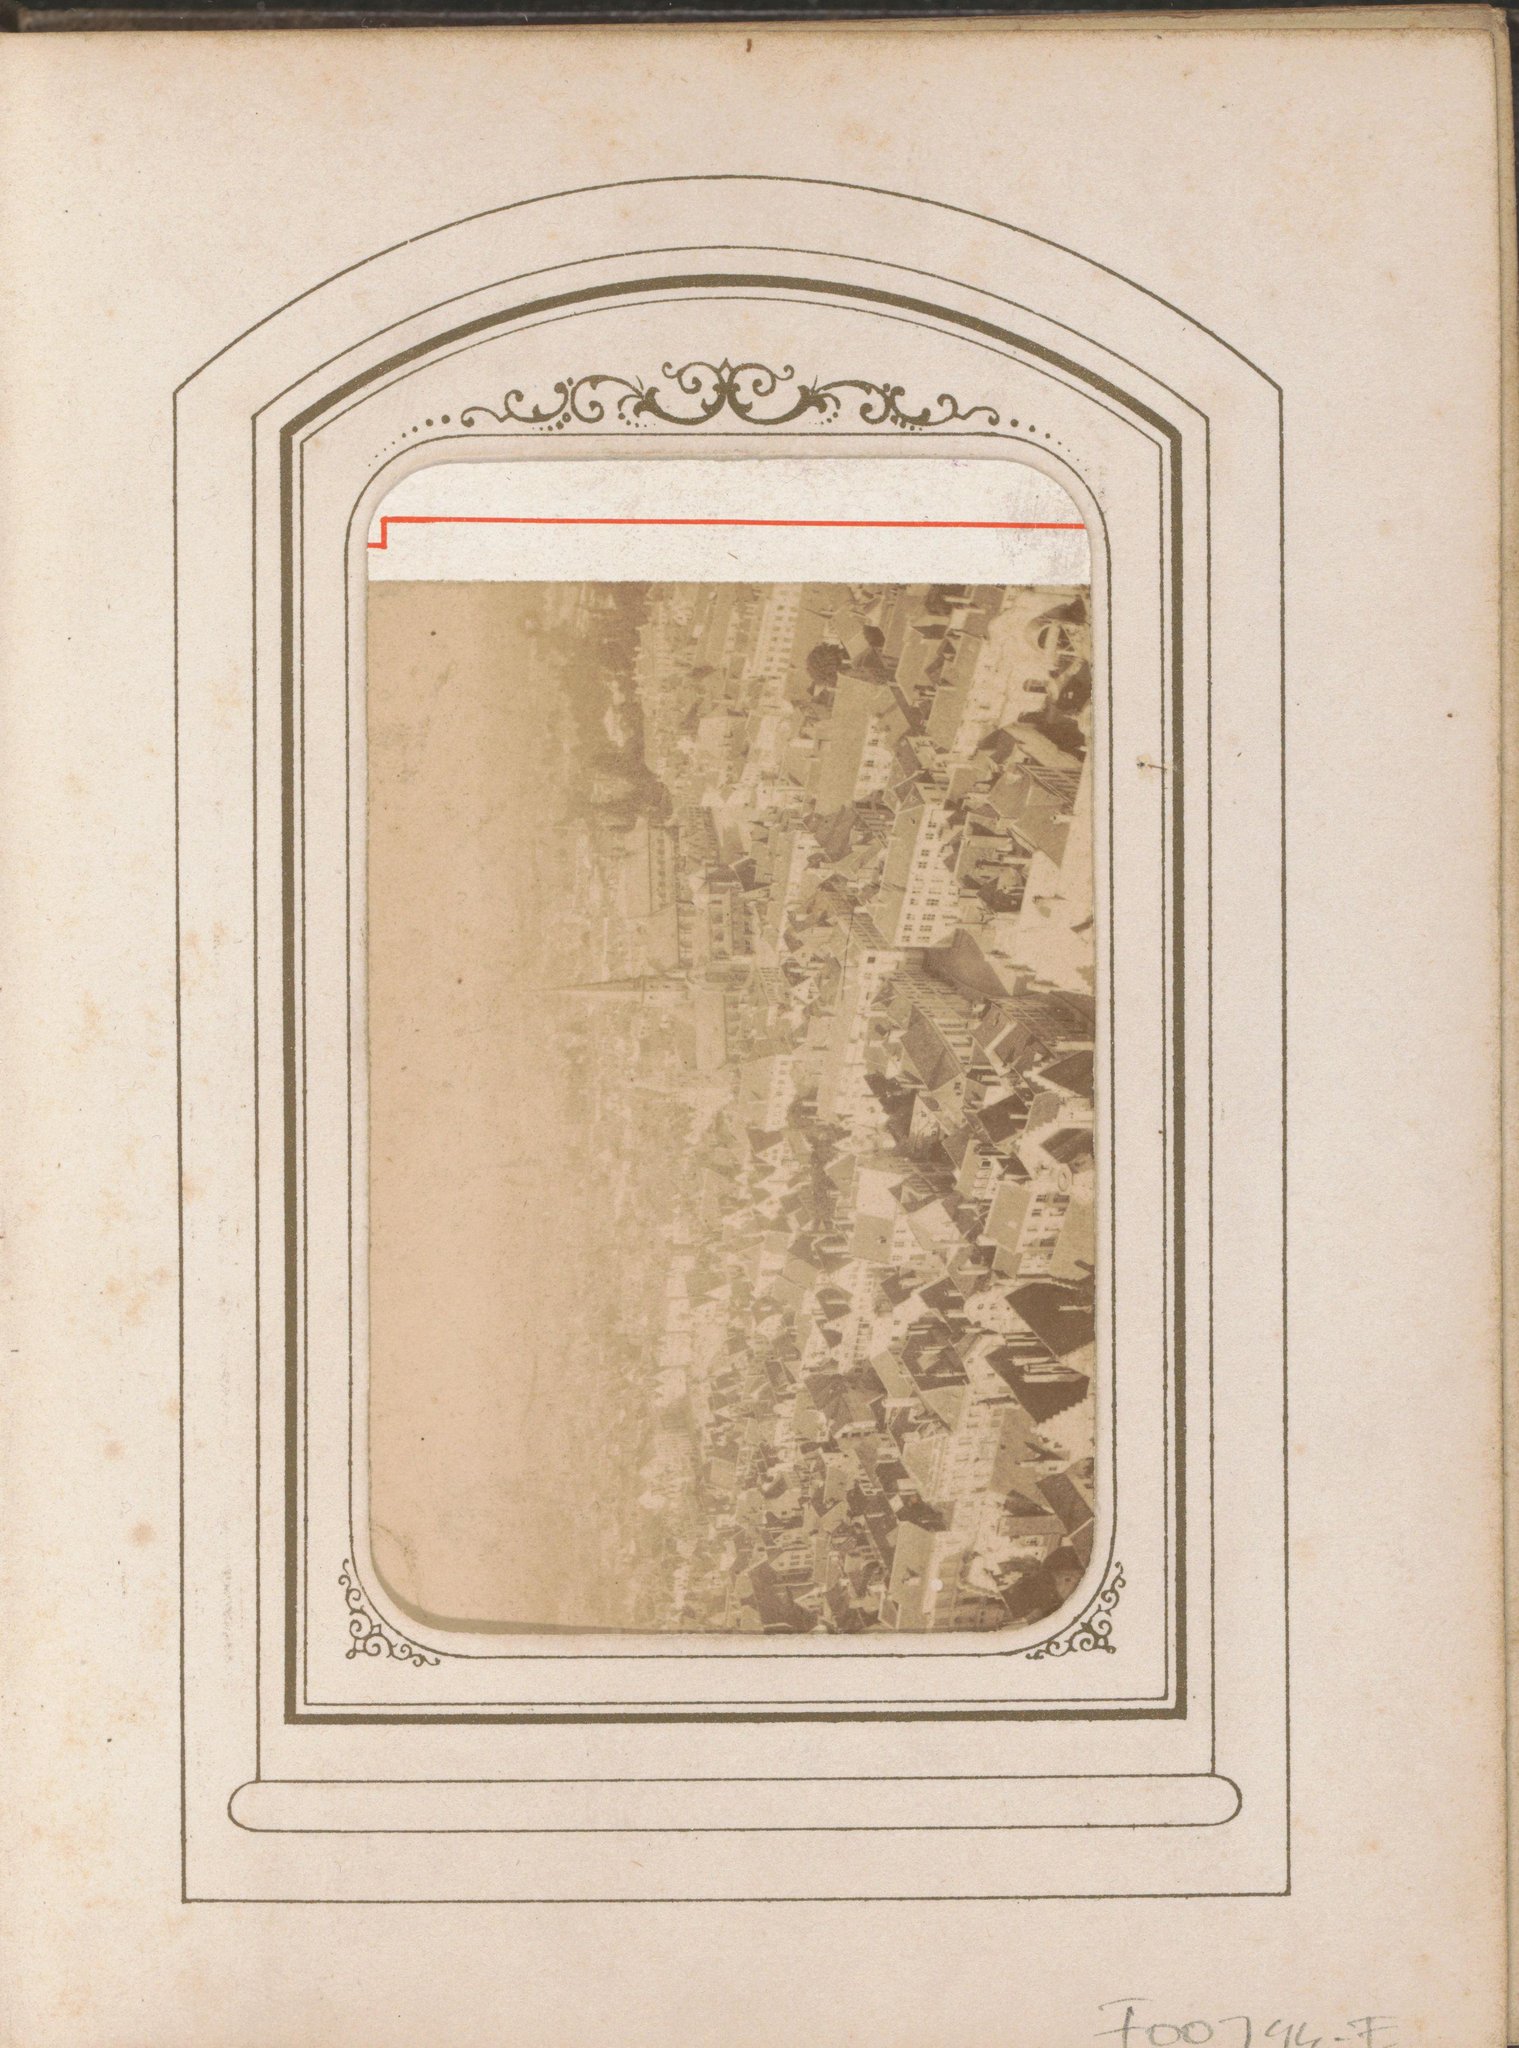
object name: photograph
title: Vue Générale de Gand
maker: Anonymous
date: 1860-1890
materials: cardboard, paper, photographic support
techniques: albumen print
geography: ghent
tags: travelling; tourism, prospect of city, town panorama, silhouette of city, ghent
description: Onderdeel van Fotoalbum met 36 opnames van Europese landen.